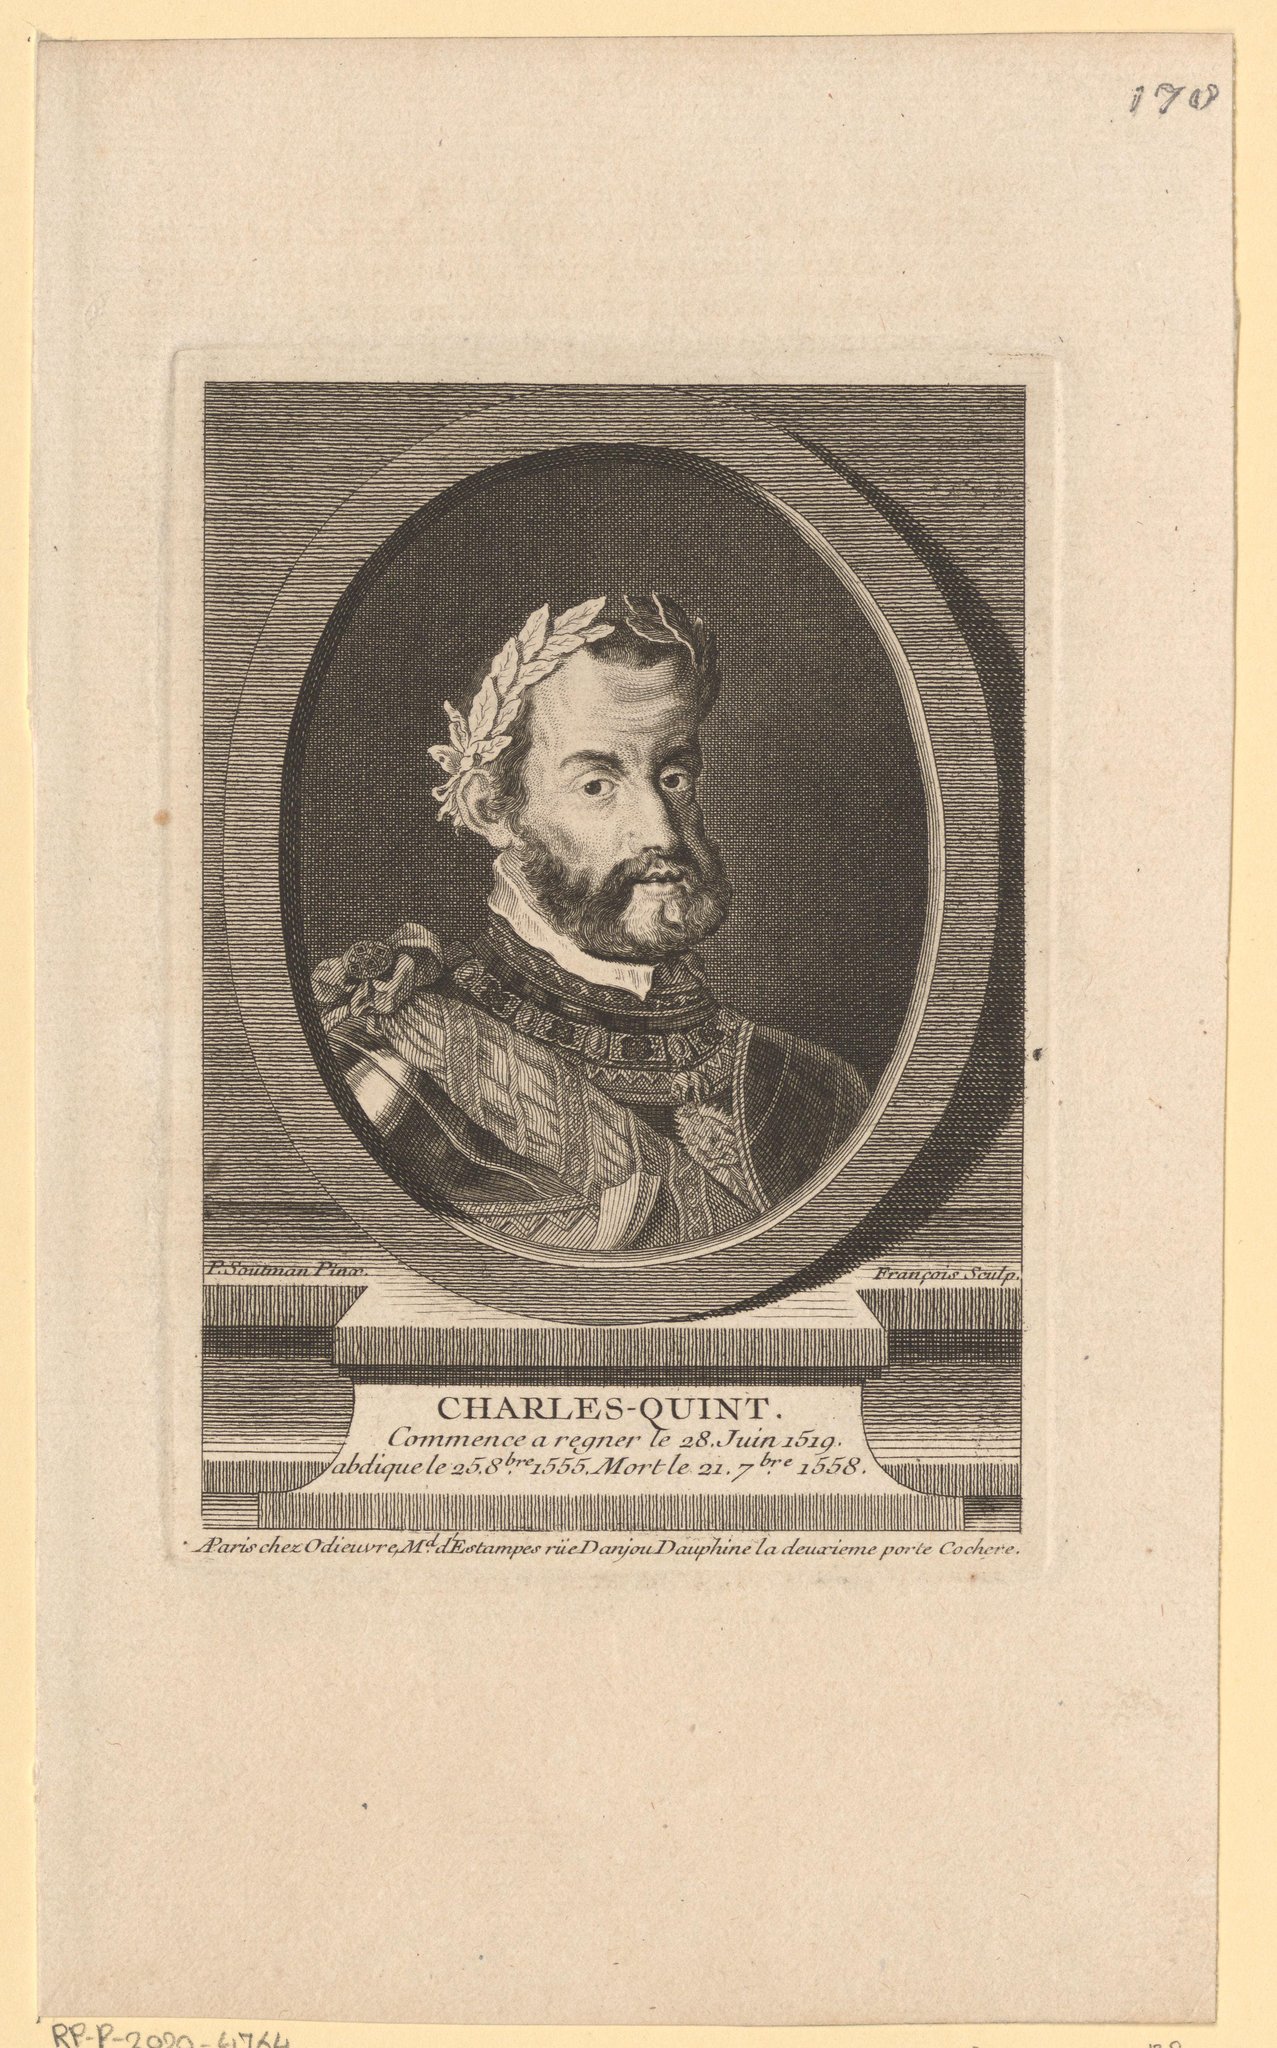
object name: print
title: Portret van keizer Karel V op 58-jarige leeftijd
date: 1755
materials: paper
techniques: engraving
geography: paris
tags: ghent, charles v (holy roman emperor and king of spain), double-headed eagle, historical persons, knighthood order of the golden fleece, king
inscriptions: collector's mark: Lugt 2228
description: Prent mogelijk uit: Dreux du Radier, Jean François. L'Europe illustré, contenant l'histoire abregée. Parijs: Michel Odieuvre en André le Breton, 1755, dl. 2. Of uit een latere editie (1774, 1777, 1778).